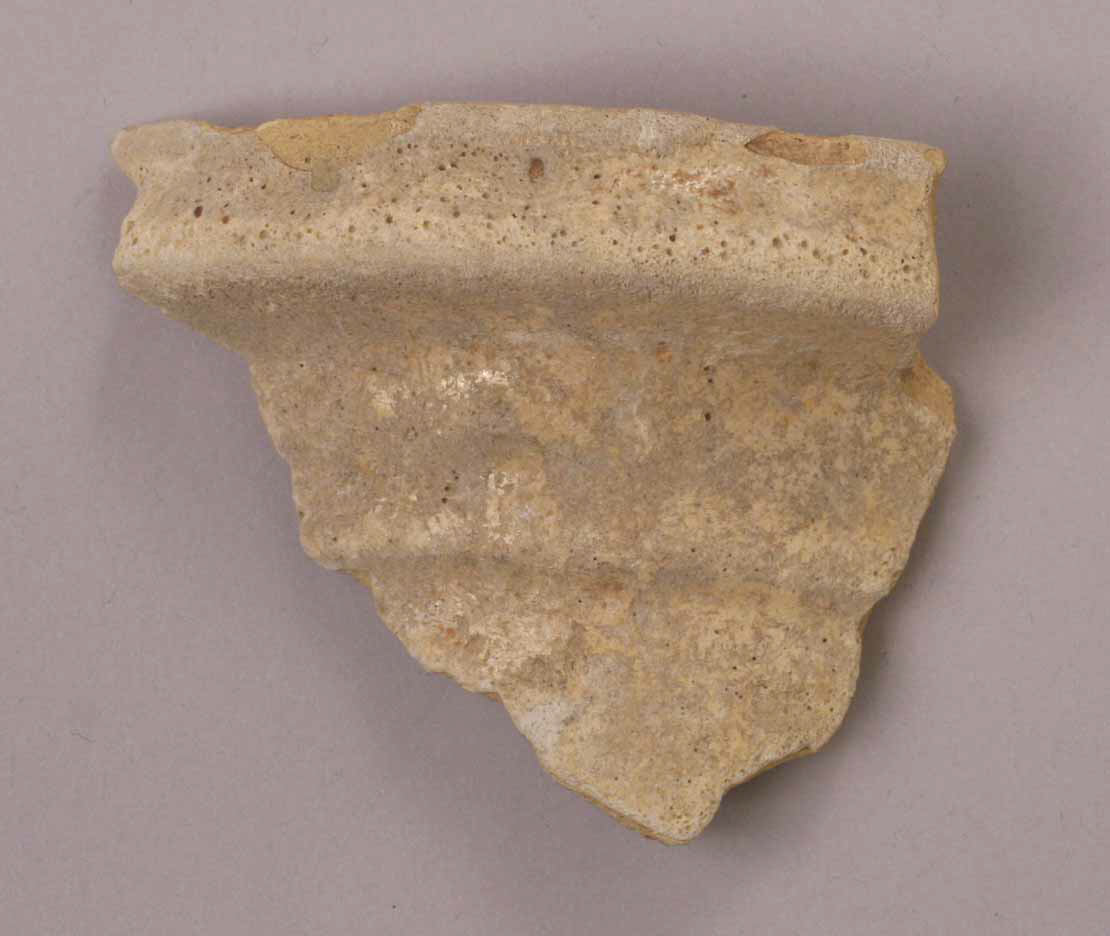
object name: fragment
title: Ceramic Fragment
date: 201-800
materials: earthenware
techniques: glazing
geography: iraq